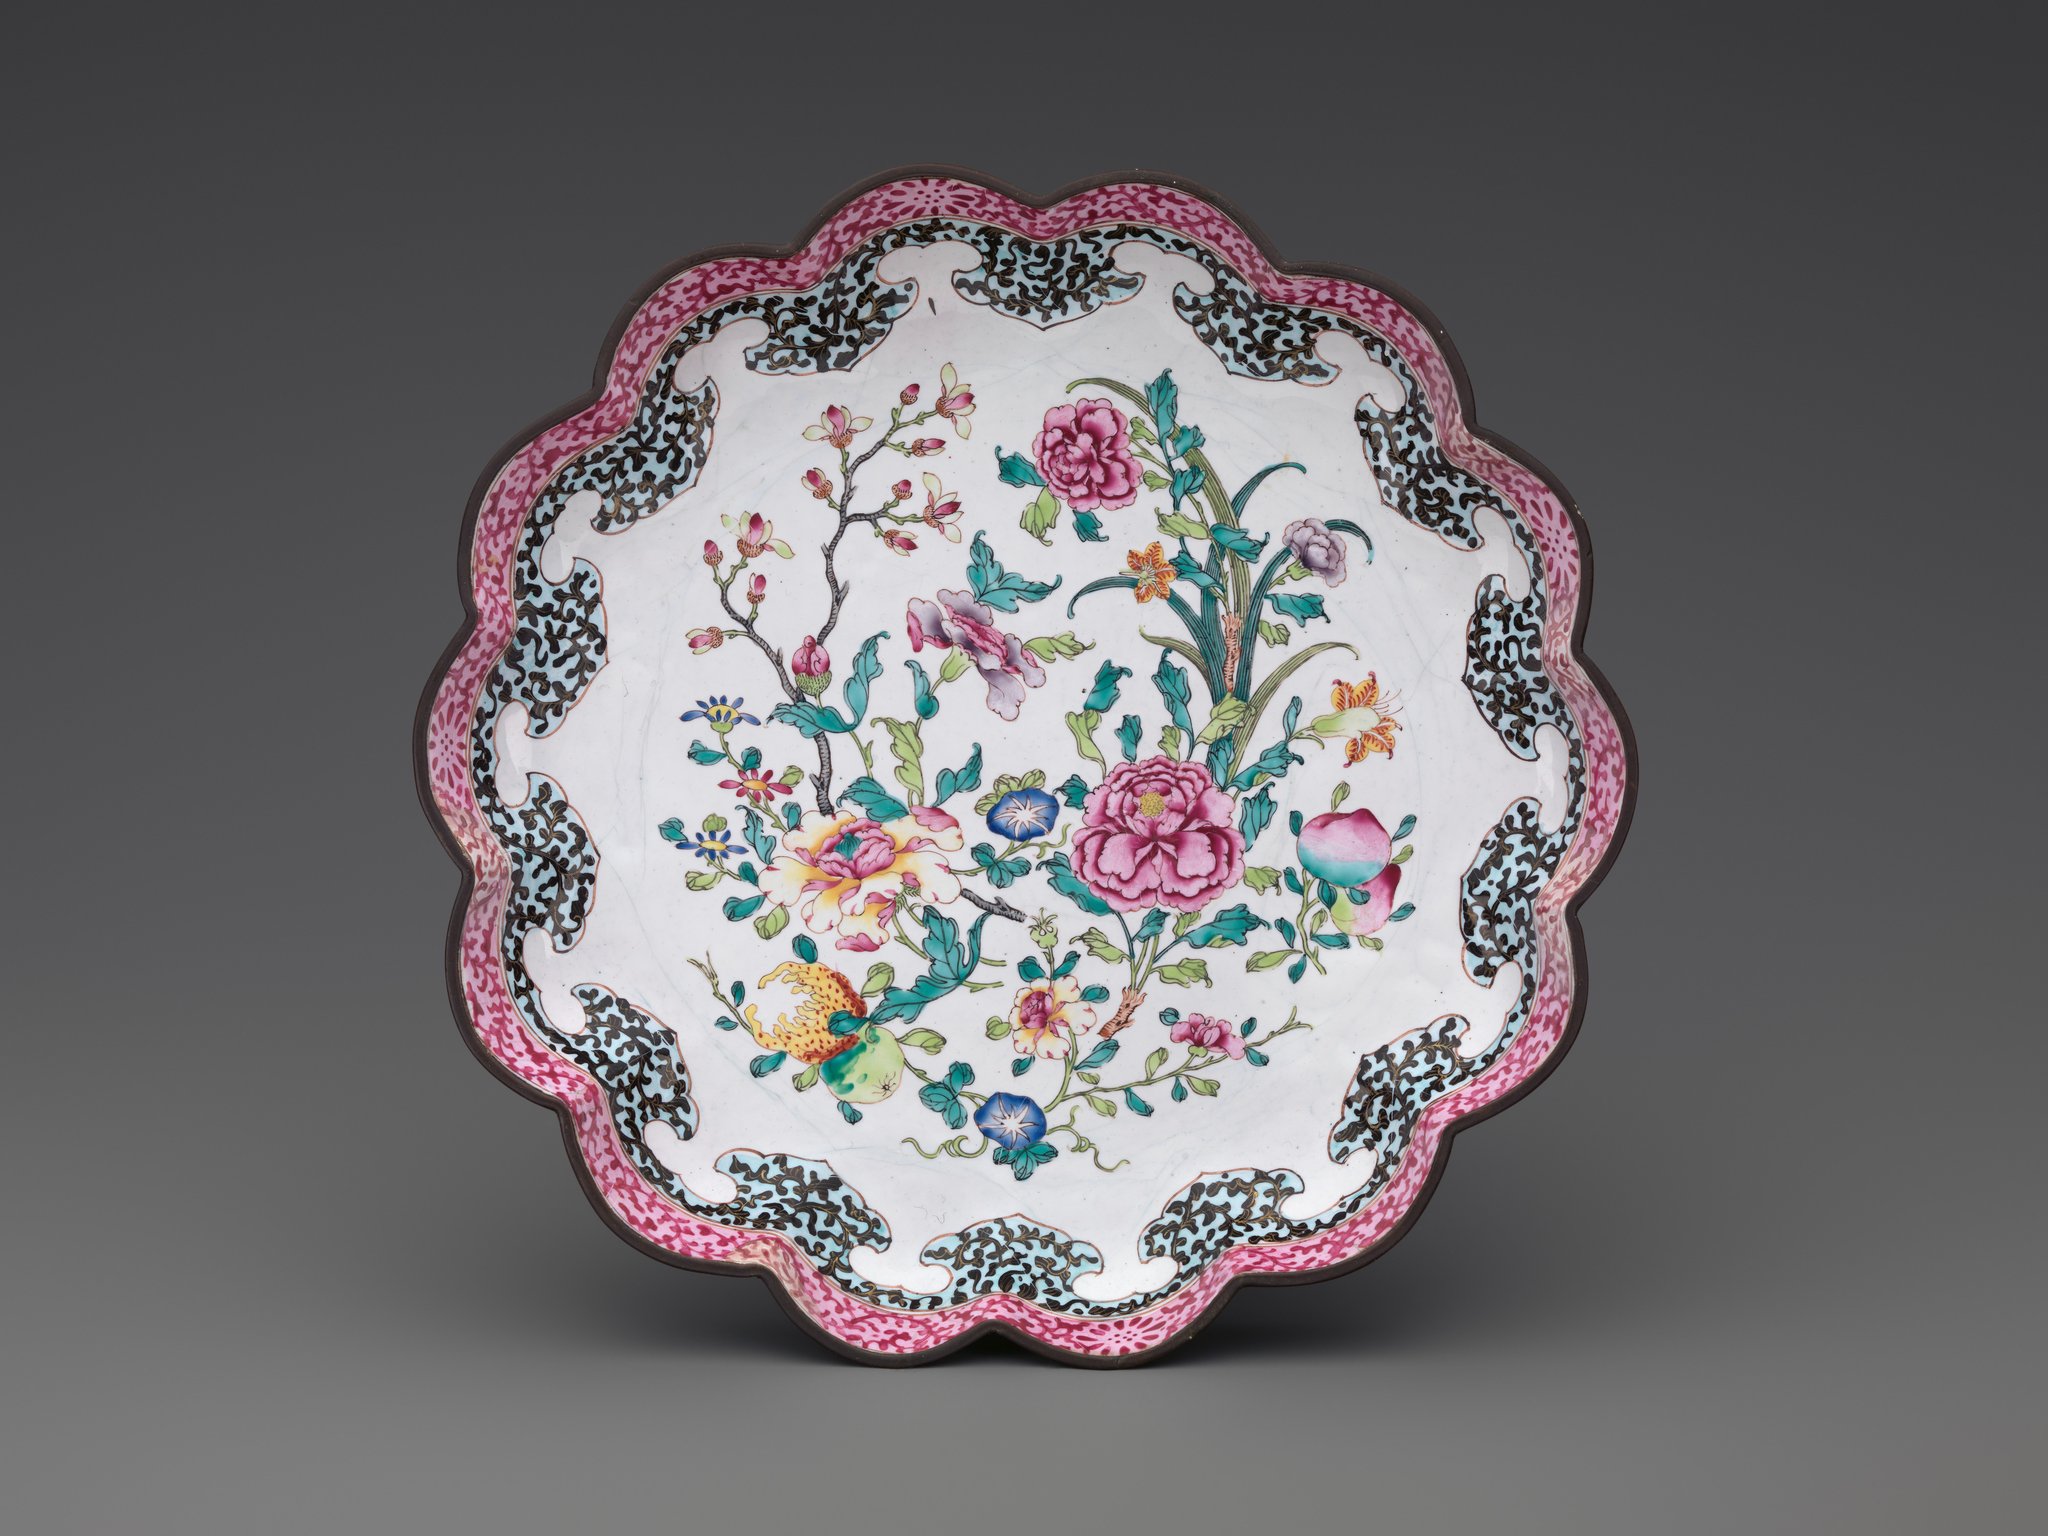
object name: dish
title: Dish with auspicious flowers and fruits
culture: chinese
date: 1701-1800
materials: copper alloy, enamel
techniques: painting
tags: fruit,flowers